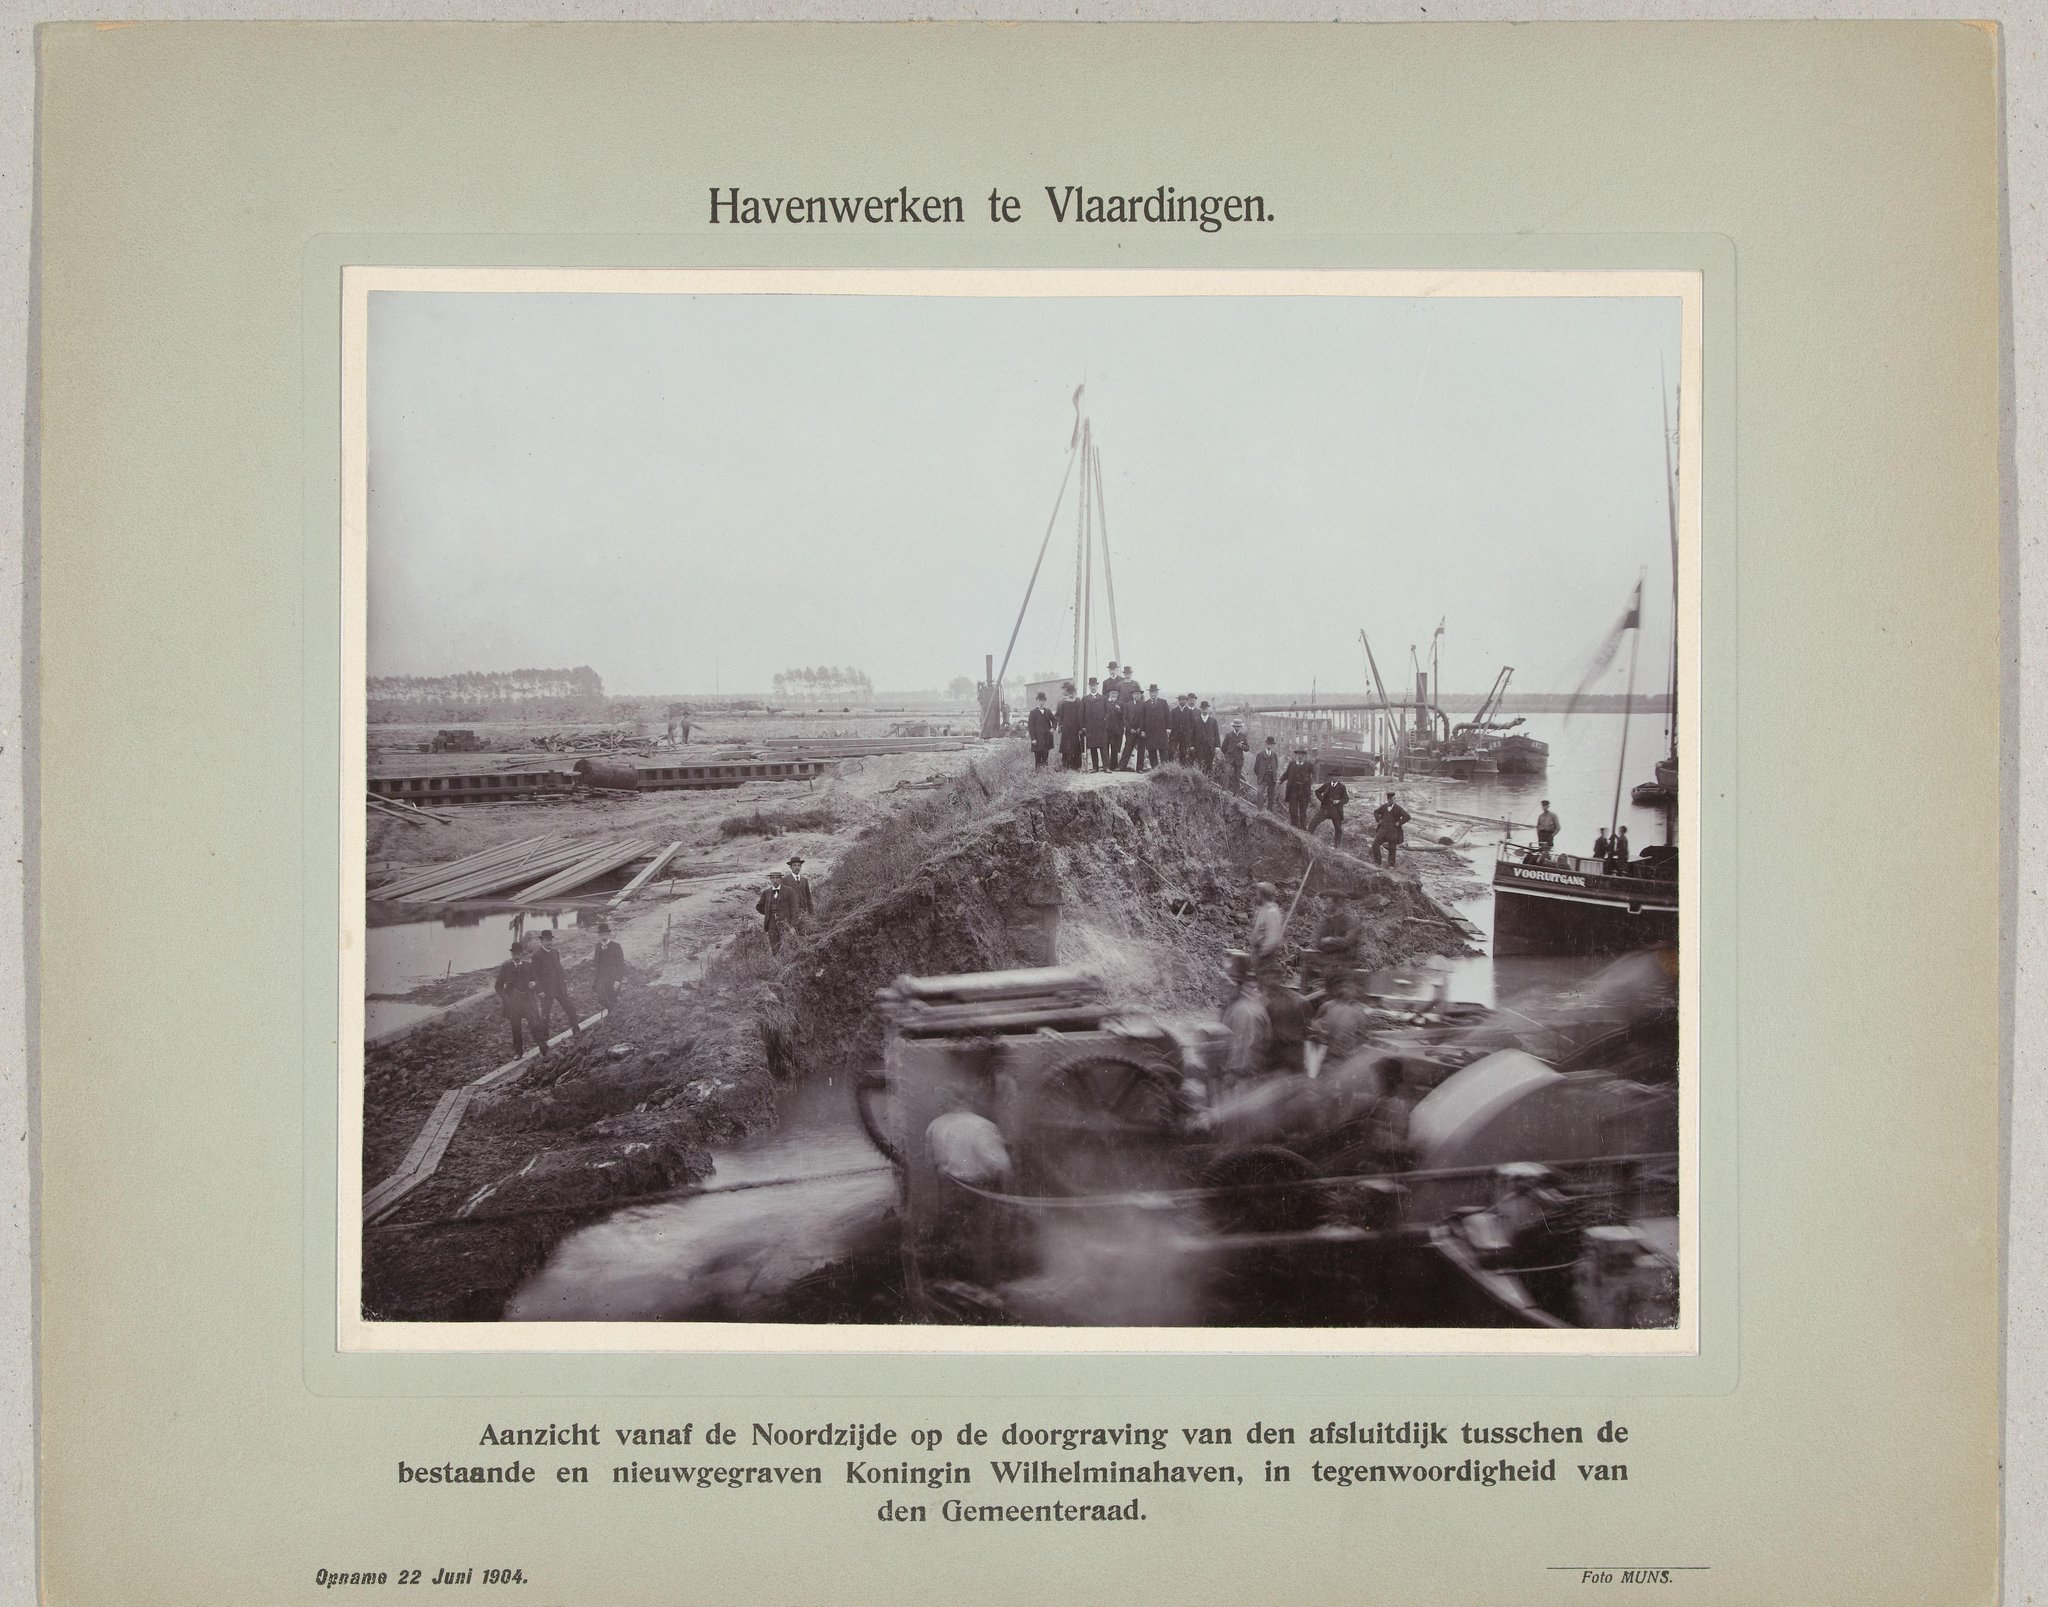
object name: photograph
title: Havenwerken te Vlaardingen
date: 1904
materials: cardboard, paper, photographic support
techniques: albumen print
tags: harbour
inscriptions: signature and date: ‘Rechtsonder de foto gedrukt: Foto Muns. Linksonder gedrukt: Opname 22 Juni 1904.’, inscription: ‘Boven de foto gedrukt: Havenwerken te Vlaardingen. Onder de foto gedrukt: Aanzicht vanaf de Noordzijde op de doorgraving van den afsluitdijk tusschen de bestaande en nieuwgegraven Koningin Wilhelminahaven, in tegenwoordigheid van den Gemeenteraad.’